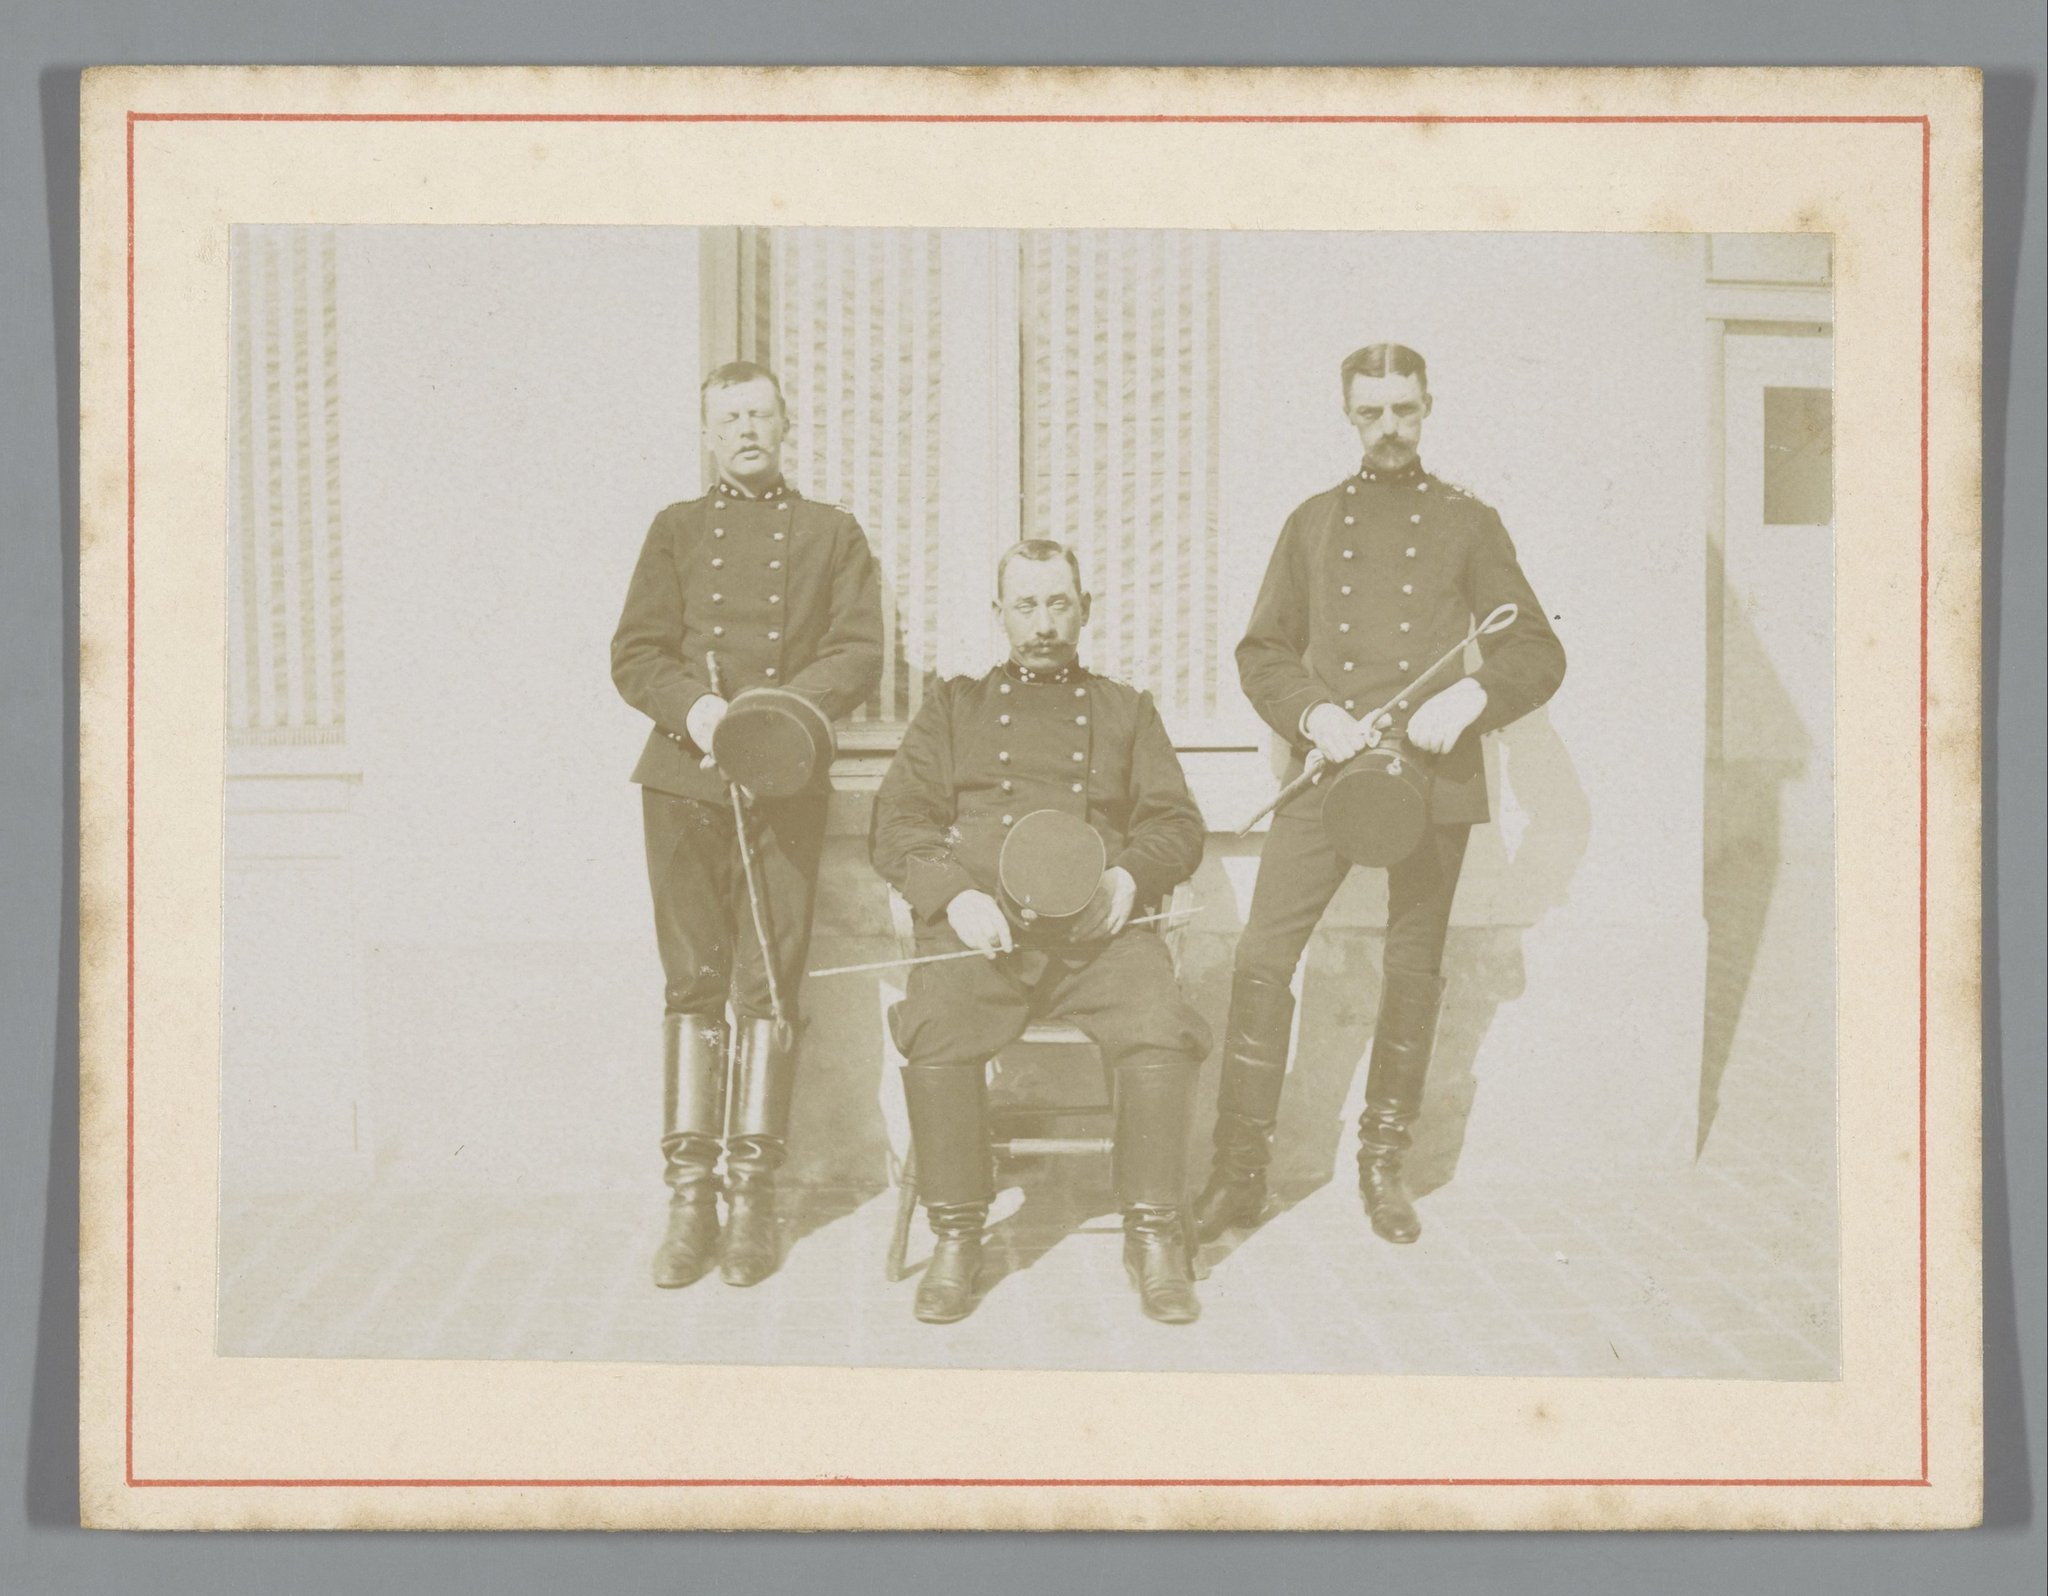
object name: photograph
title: Groepsportret van drie onbekende militairen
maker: karel alexander enklaar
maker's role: fotograaf, luitenant, militair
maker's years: 1858-1943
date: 1892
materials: paper, cardboard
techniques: collodion silver print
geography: bergen op zoom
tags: land forces, (military) uniforms, anonymous historical persons portrayed in a group, in a group-portrait, bergen op zoom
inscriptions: collector's mark: ‘Vosmaer’